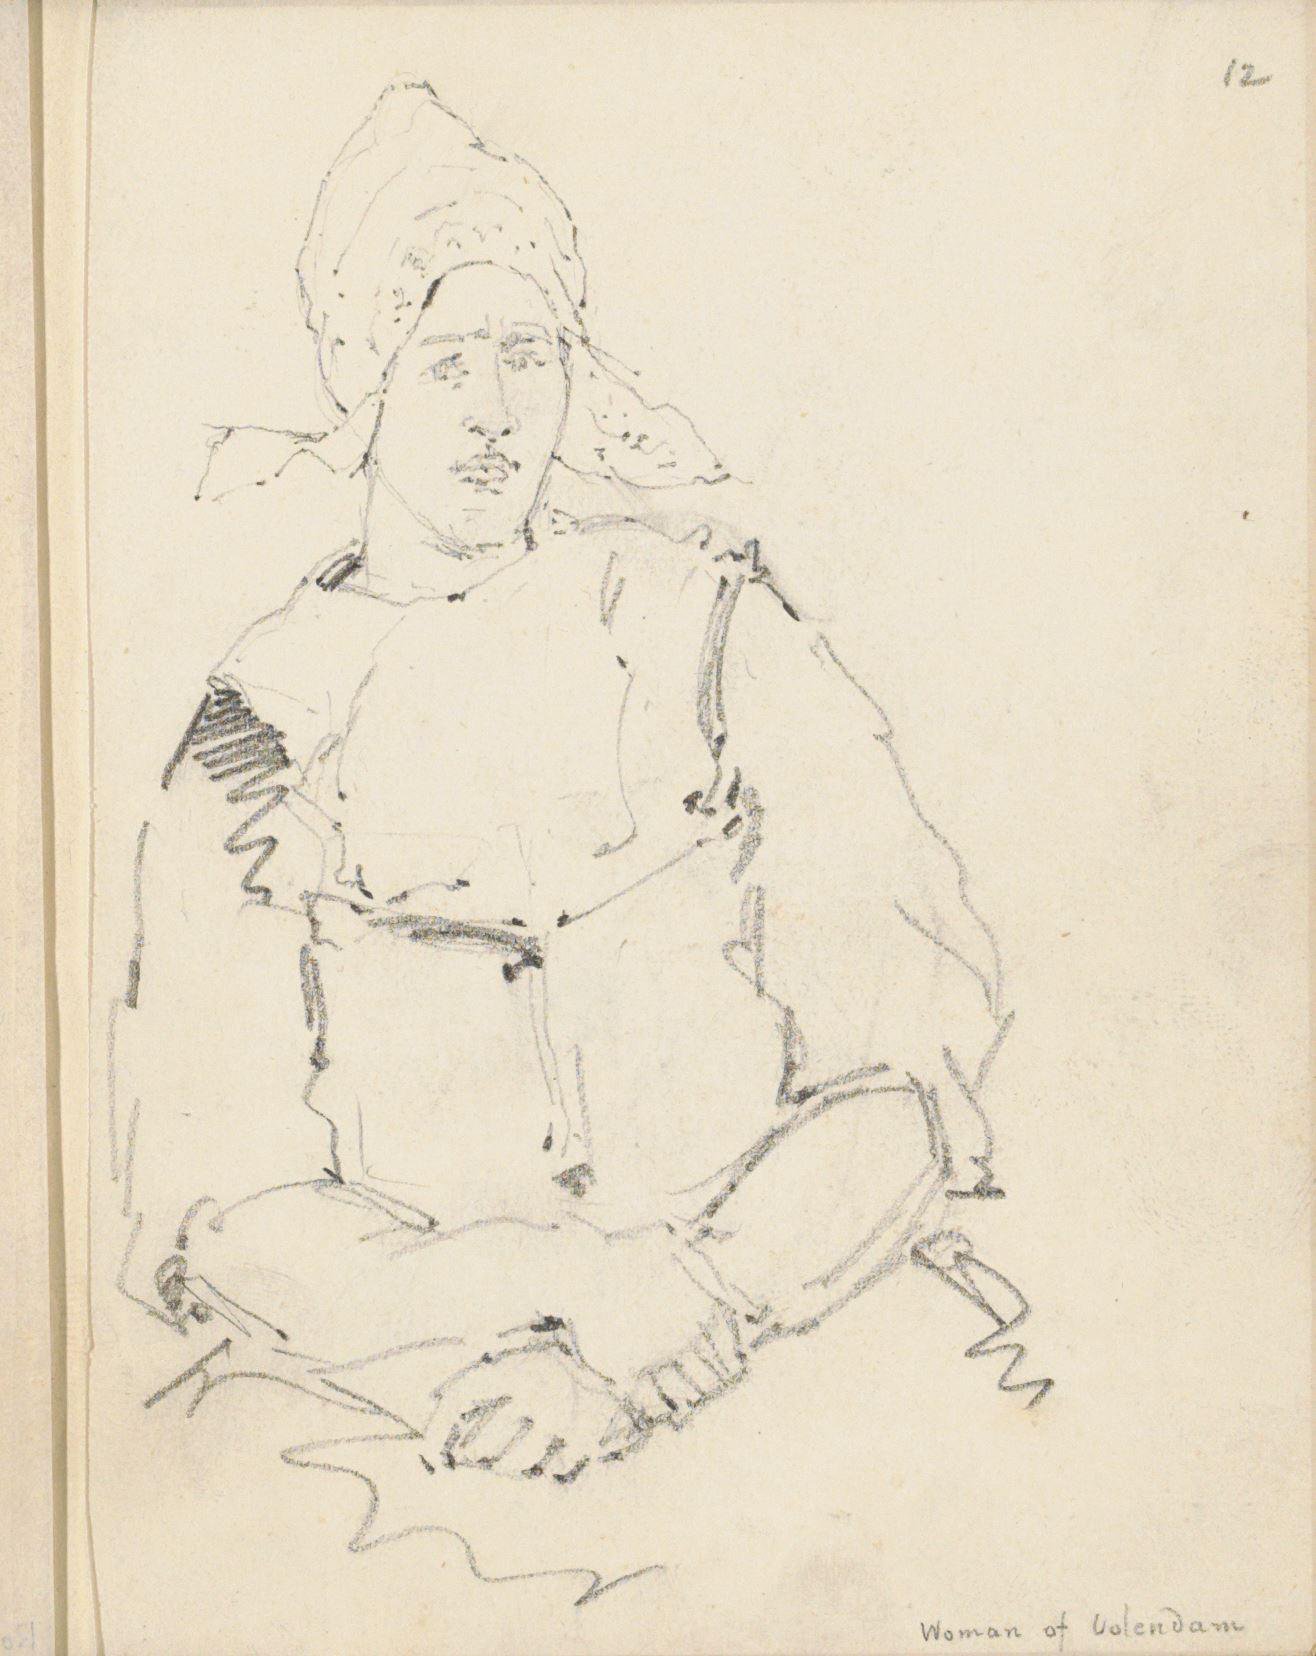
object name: sketchbook leaf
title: Zittende vrouw in Volendammer kostuum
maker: alfred william rich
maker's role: draughtsman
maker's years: 1856-1921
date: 1892-1893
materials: paper, pencil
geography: volendam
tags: folk costume, regional costume (+ women's clothes)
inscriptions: annotation: ‘woman of Volendam’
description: Blad 12 recto uit een schetsboek met 86 bladen.